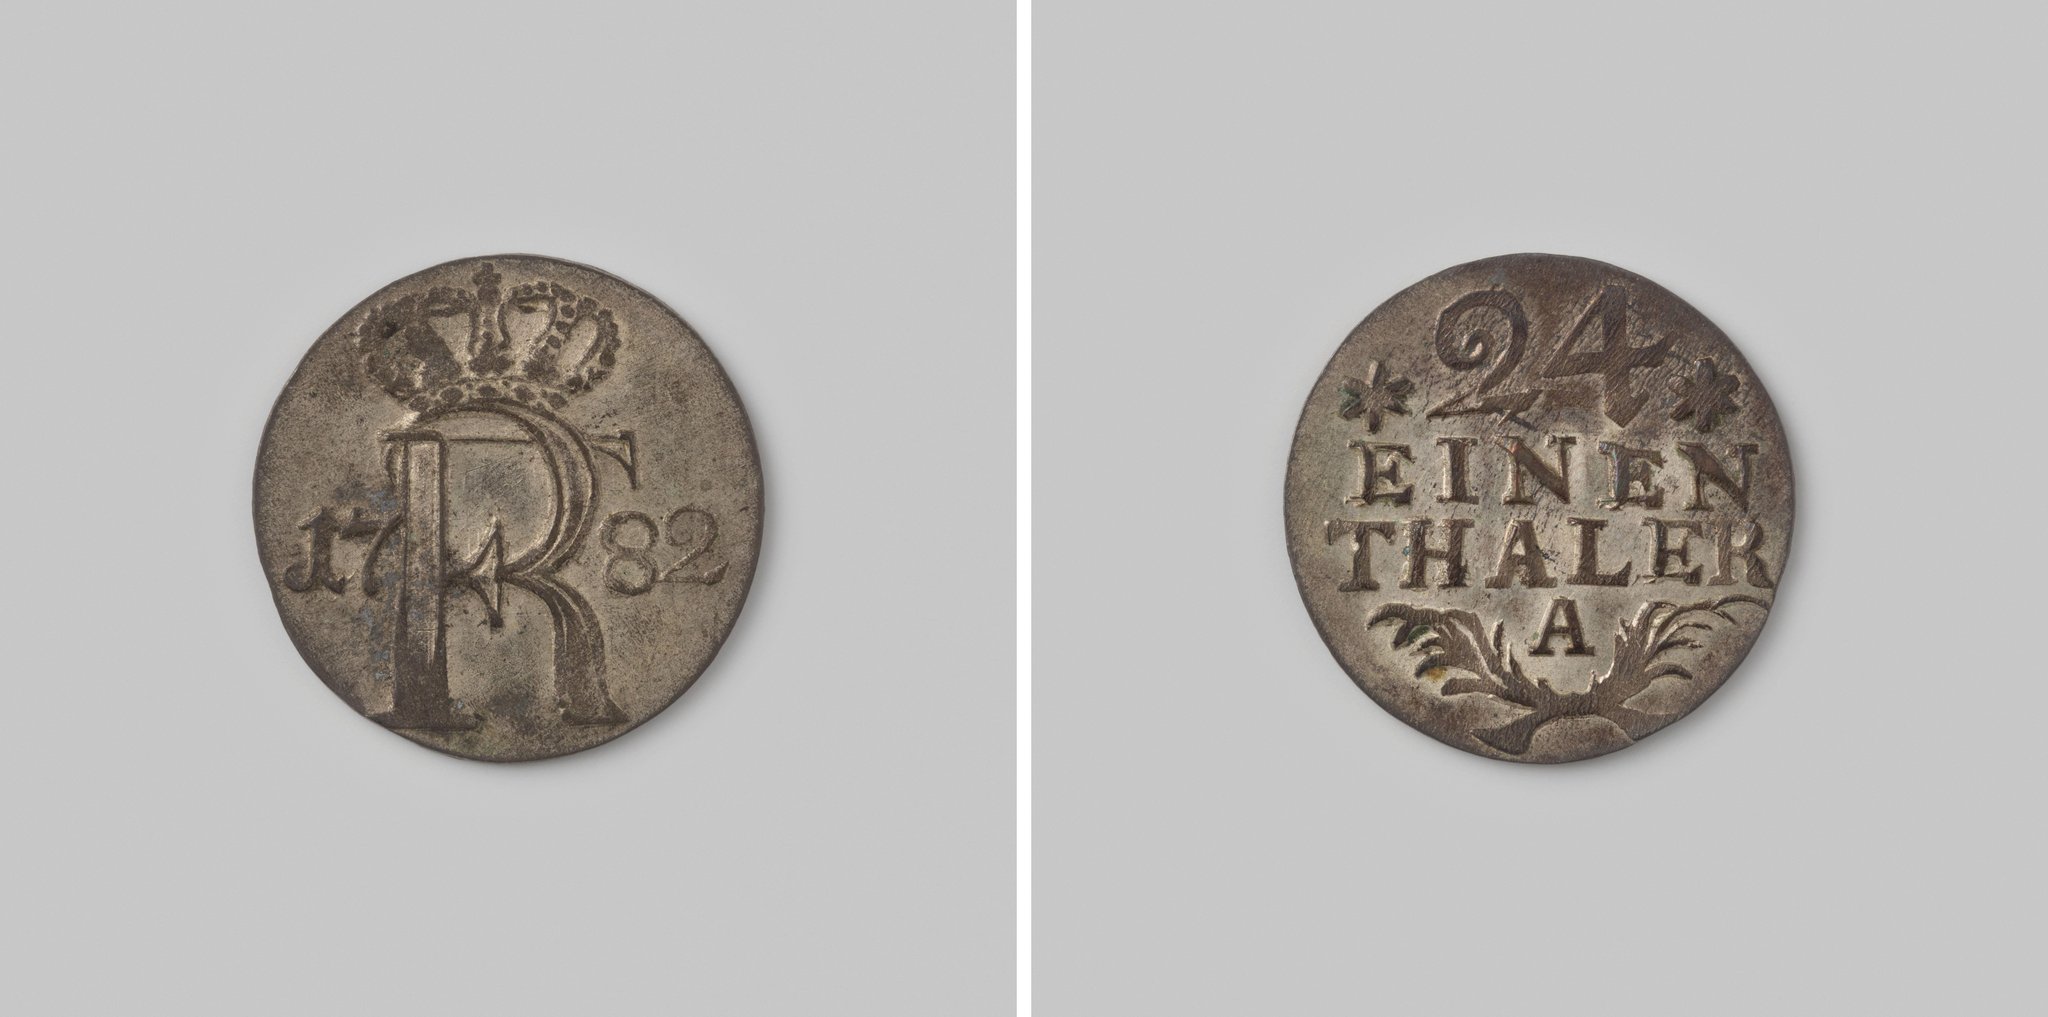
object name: vierentwintigste taler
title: Pruisen-Brandenburg, koning Friedrich II, groschen, 1782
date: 1782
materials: silver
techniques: striking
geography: berlin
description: Zilveren munt. Voorzijde: tussen jaartal gekrond monogram van de koning. Keerzijde: boven twee gekruiste takken waarde-aanduiding: 24 einen Thaler in drie regels, waaronder letter A. Gladde rand.